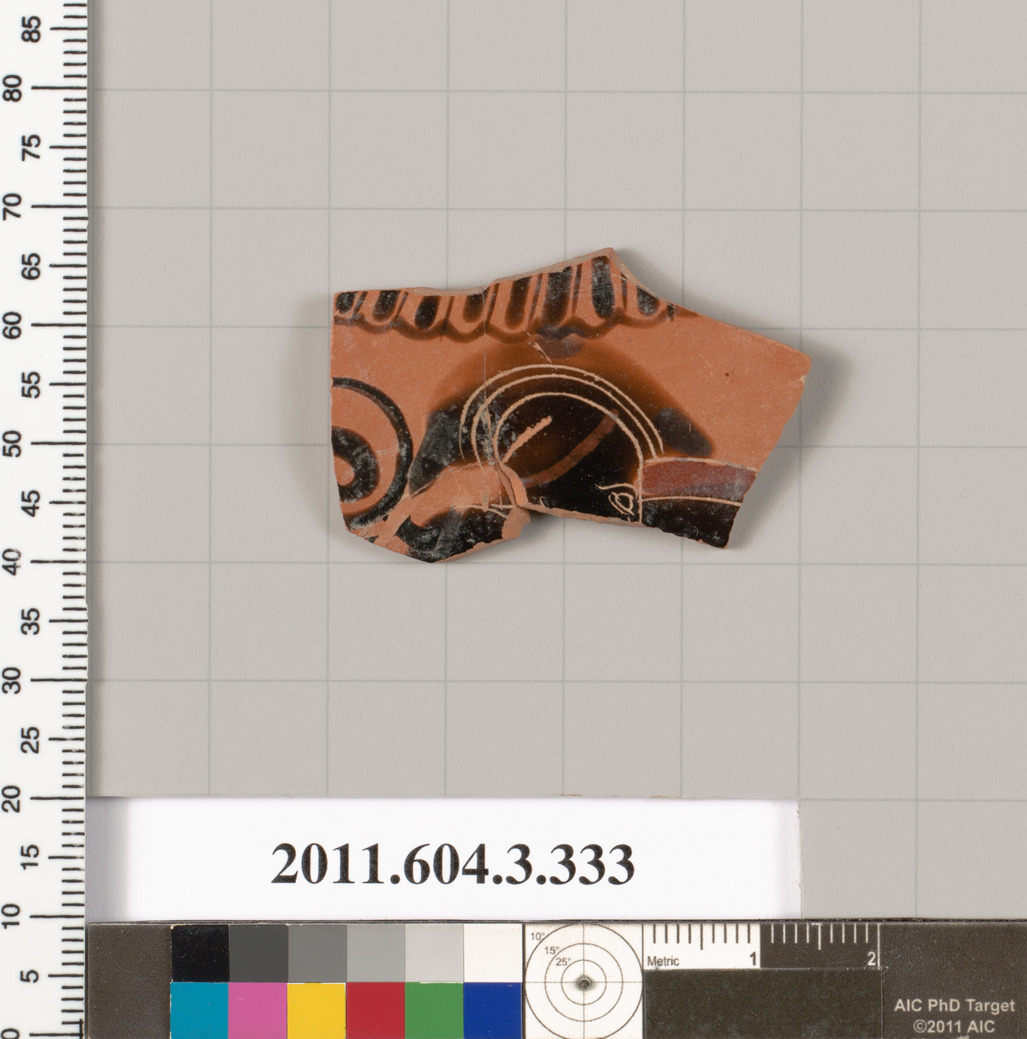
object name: neck amphora fragment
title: Terracotta fragment of a neck-amphora (jar)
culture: greek, attic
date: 500-468 BCE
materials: terracotta